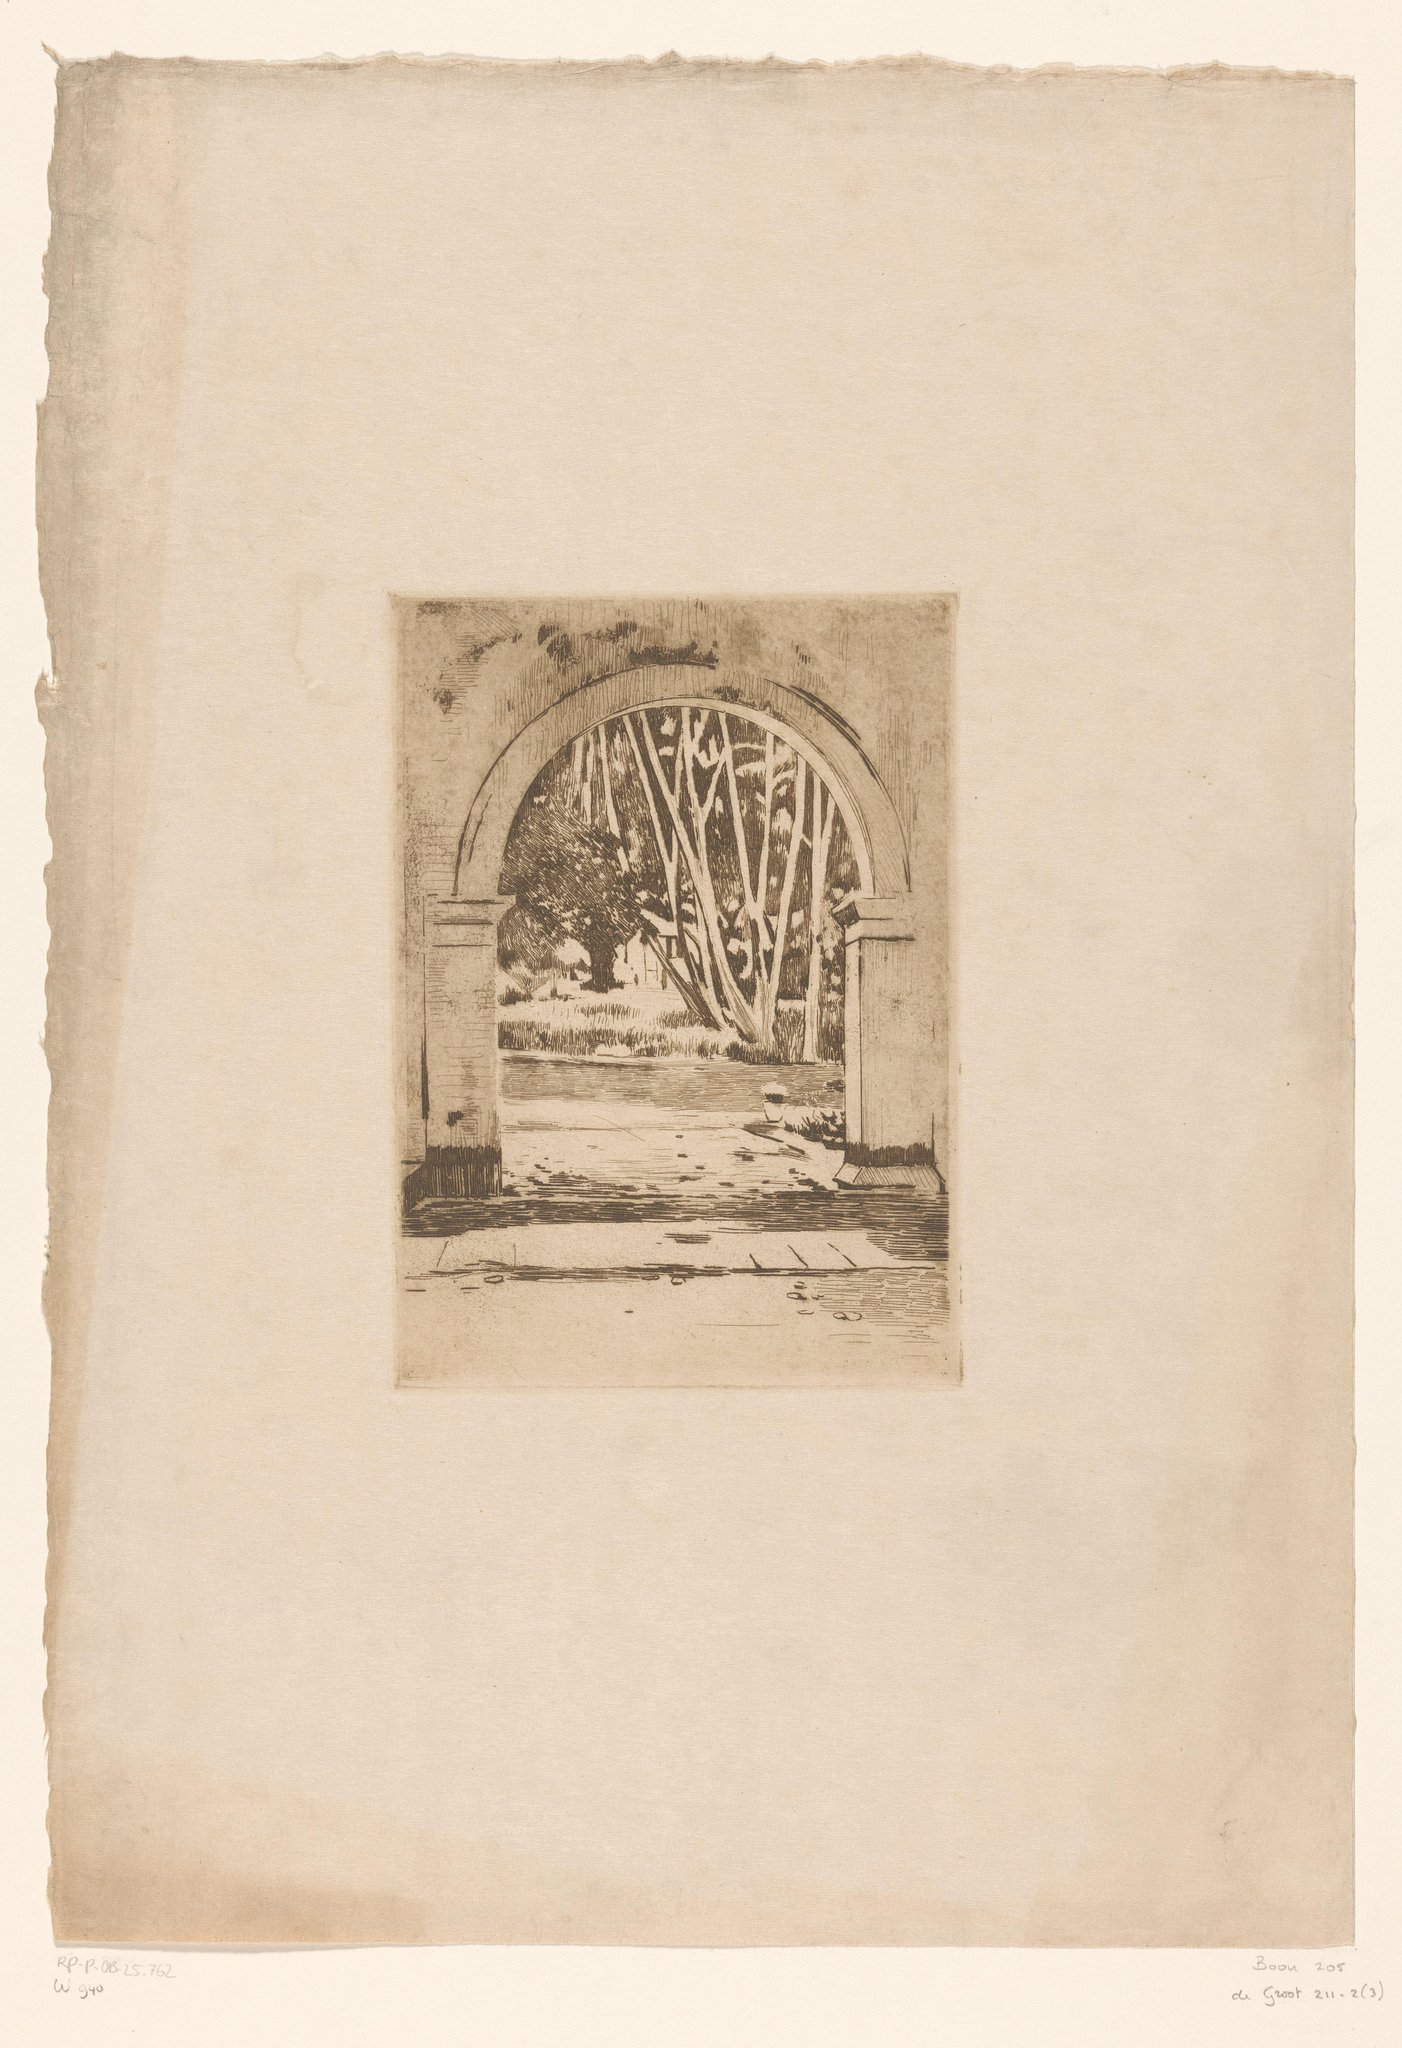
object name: print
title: Poort van Hotel Bellevue in Buitenzorg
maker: willem witsen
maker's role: draughtsman, painter, print maker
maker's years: 1860-1923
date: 1921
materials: paper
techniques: aquatint, etching, intaglio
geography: amsterdam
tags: plantation, arch, archivolt ~ architecture